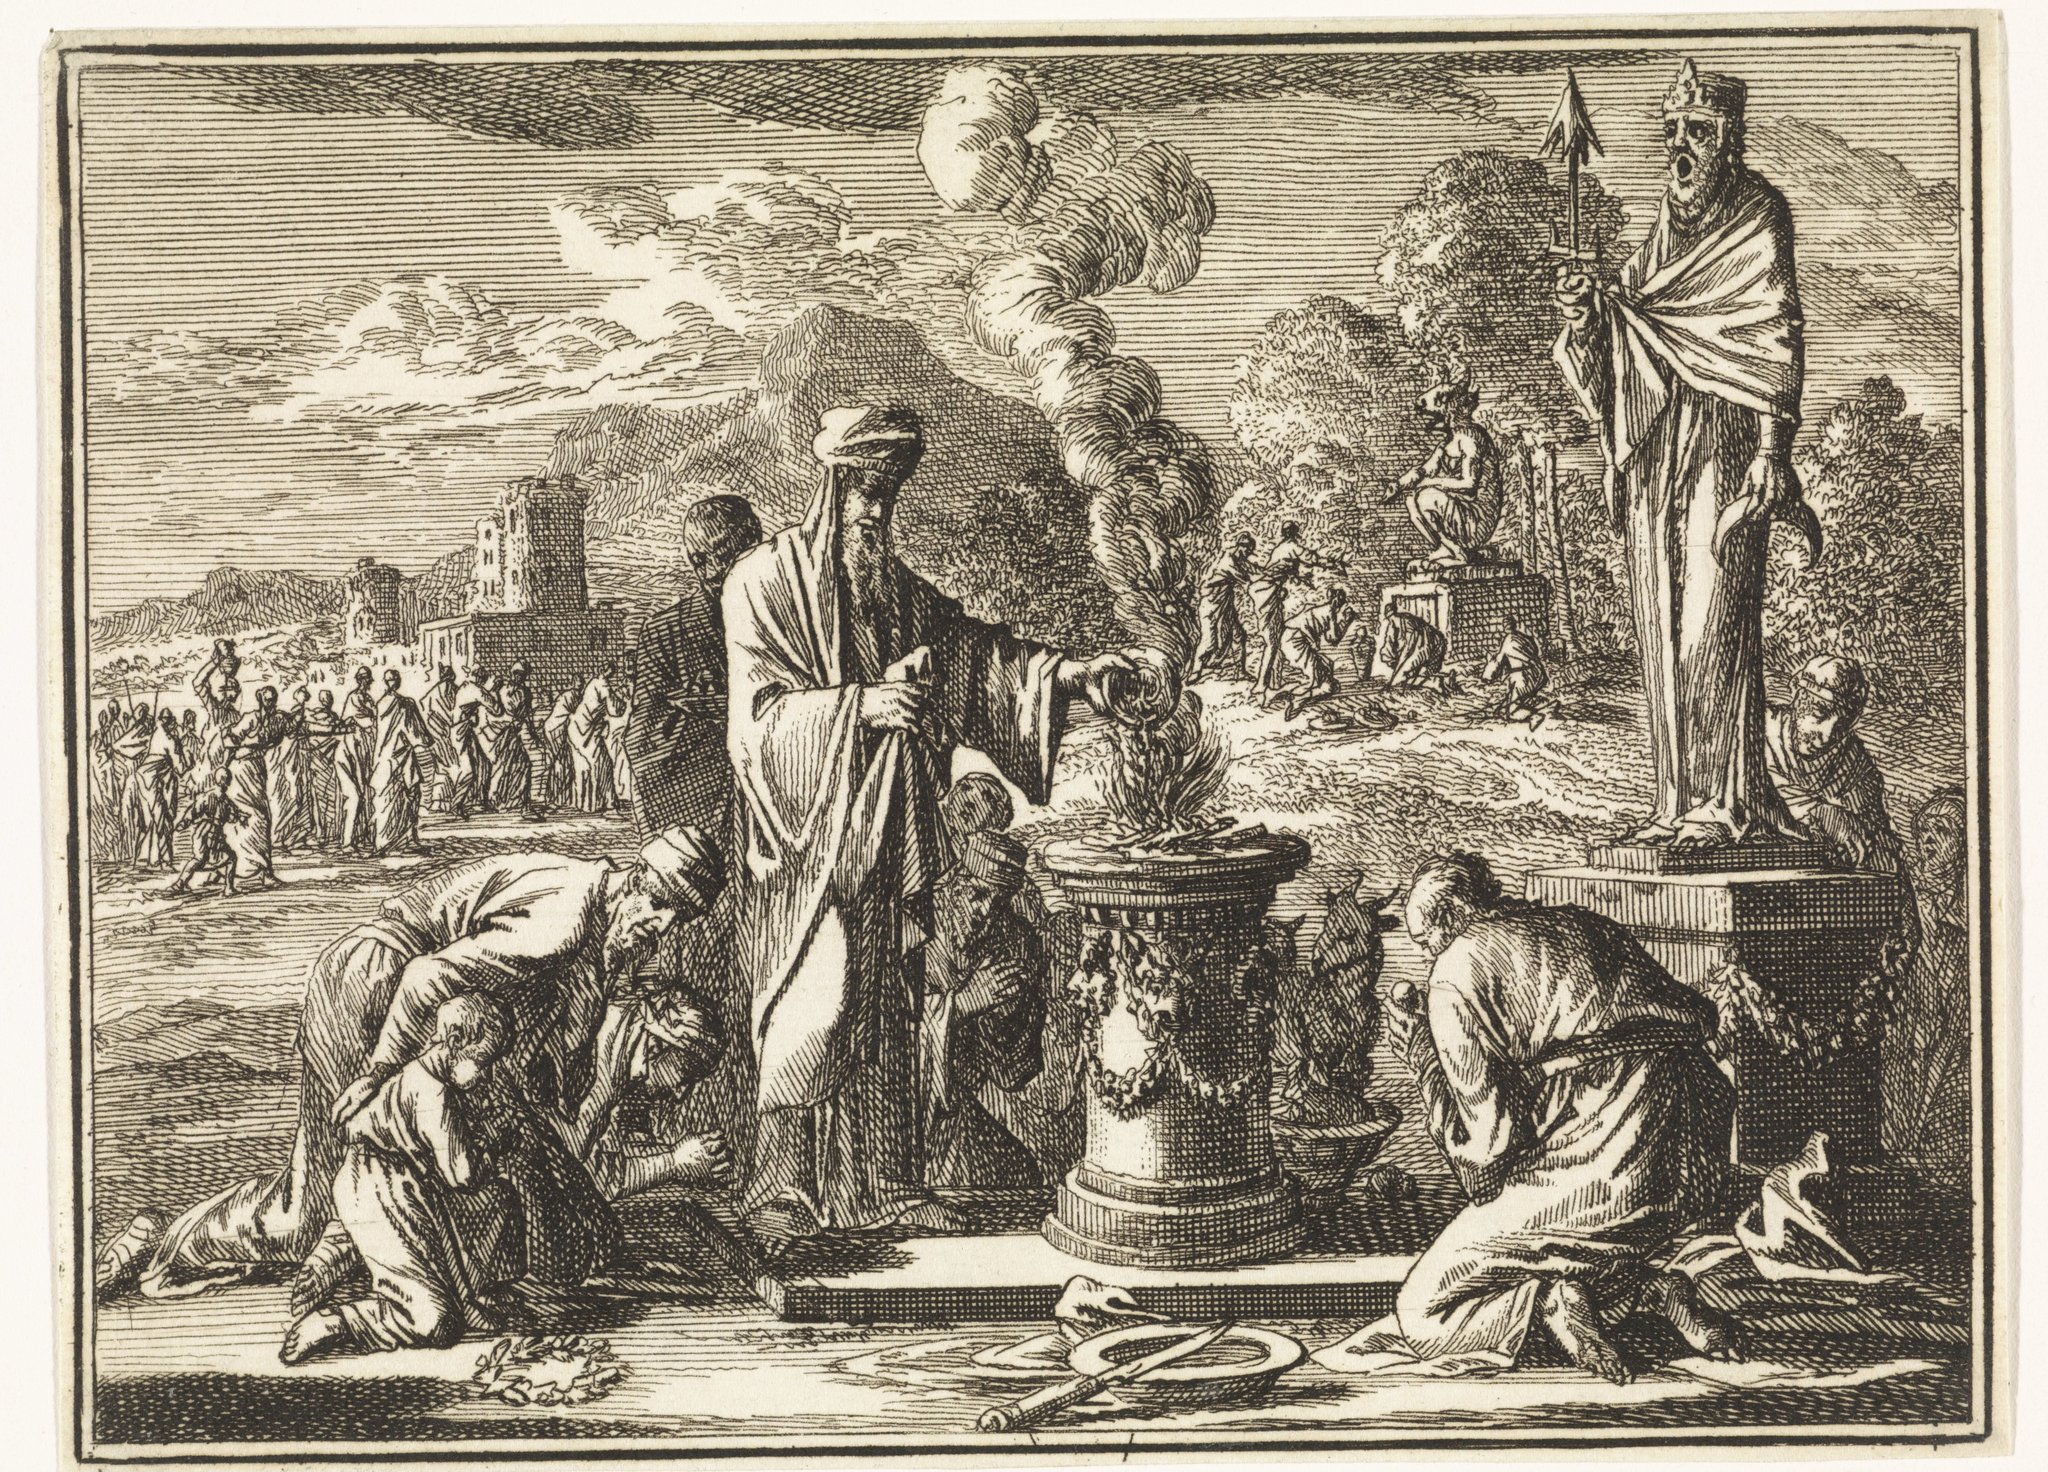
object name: print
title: Israëlieten brengen offers aan de afgodsbeelden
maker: jan luyken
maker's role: draughtsman, print maker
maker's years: 1649-1712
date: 1712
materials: paper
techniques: etching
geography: amsterdam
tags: the israelites worship baal, ashtaroth, and other idols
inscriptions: number: ‘153’, collector's mark: Lugt 2228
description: Illustratie uit: Luyken, Jan. De schriftuurlyke geschiedenissen en gelykenissen van het Oude en Nieuwe Verbond, 2 delen. Amsterdam: Wed. Pieter Arentsz II en Cornelis van der Sys, 1712, dl. I.